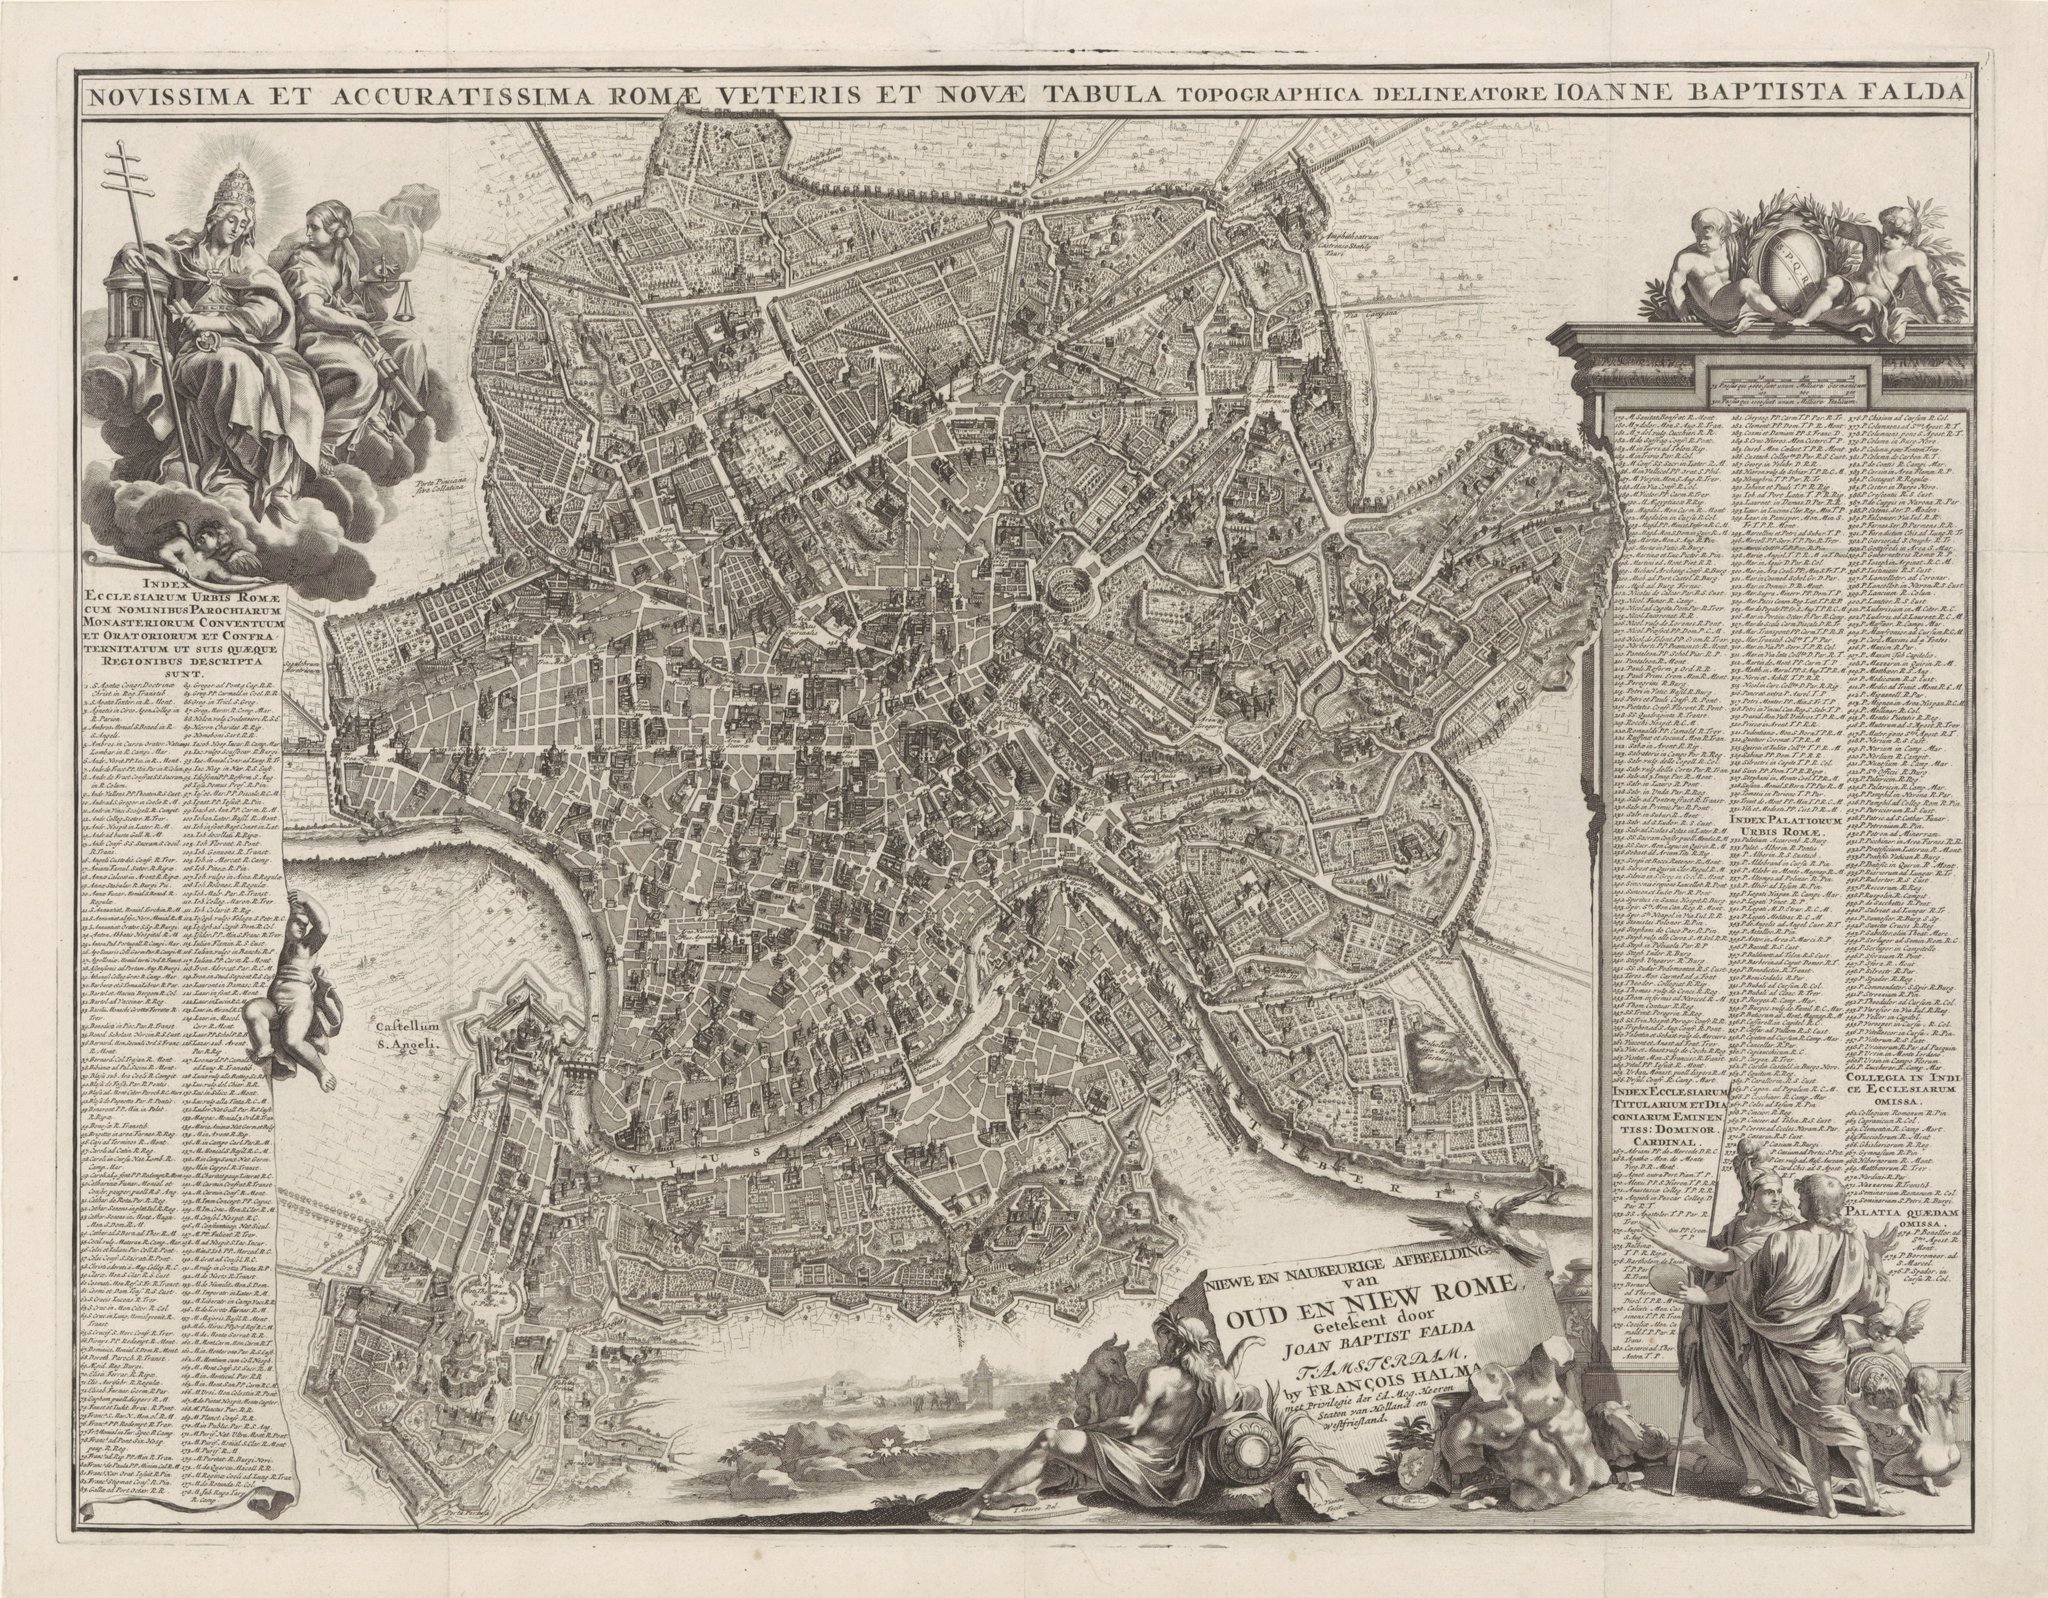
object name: print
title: Plattegrond van Rome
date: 1694-1699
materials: paper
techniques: engraving, etching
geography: utrecht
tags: maps of cities, rome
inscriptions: collector's mark: Lugt 2228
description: Illustratie voor: Joannes Georgius Graevius. Thesavrvs antiqvitatvm Romanarvm. 12 delen. Utrecht: François Halma en Leiden: Pieter van der Aa (I), 1694-1699.